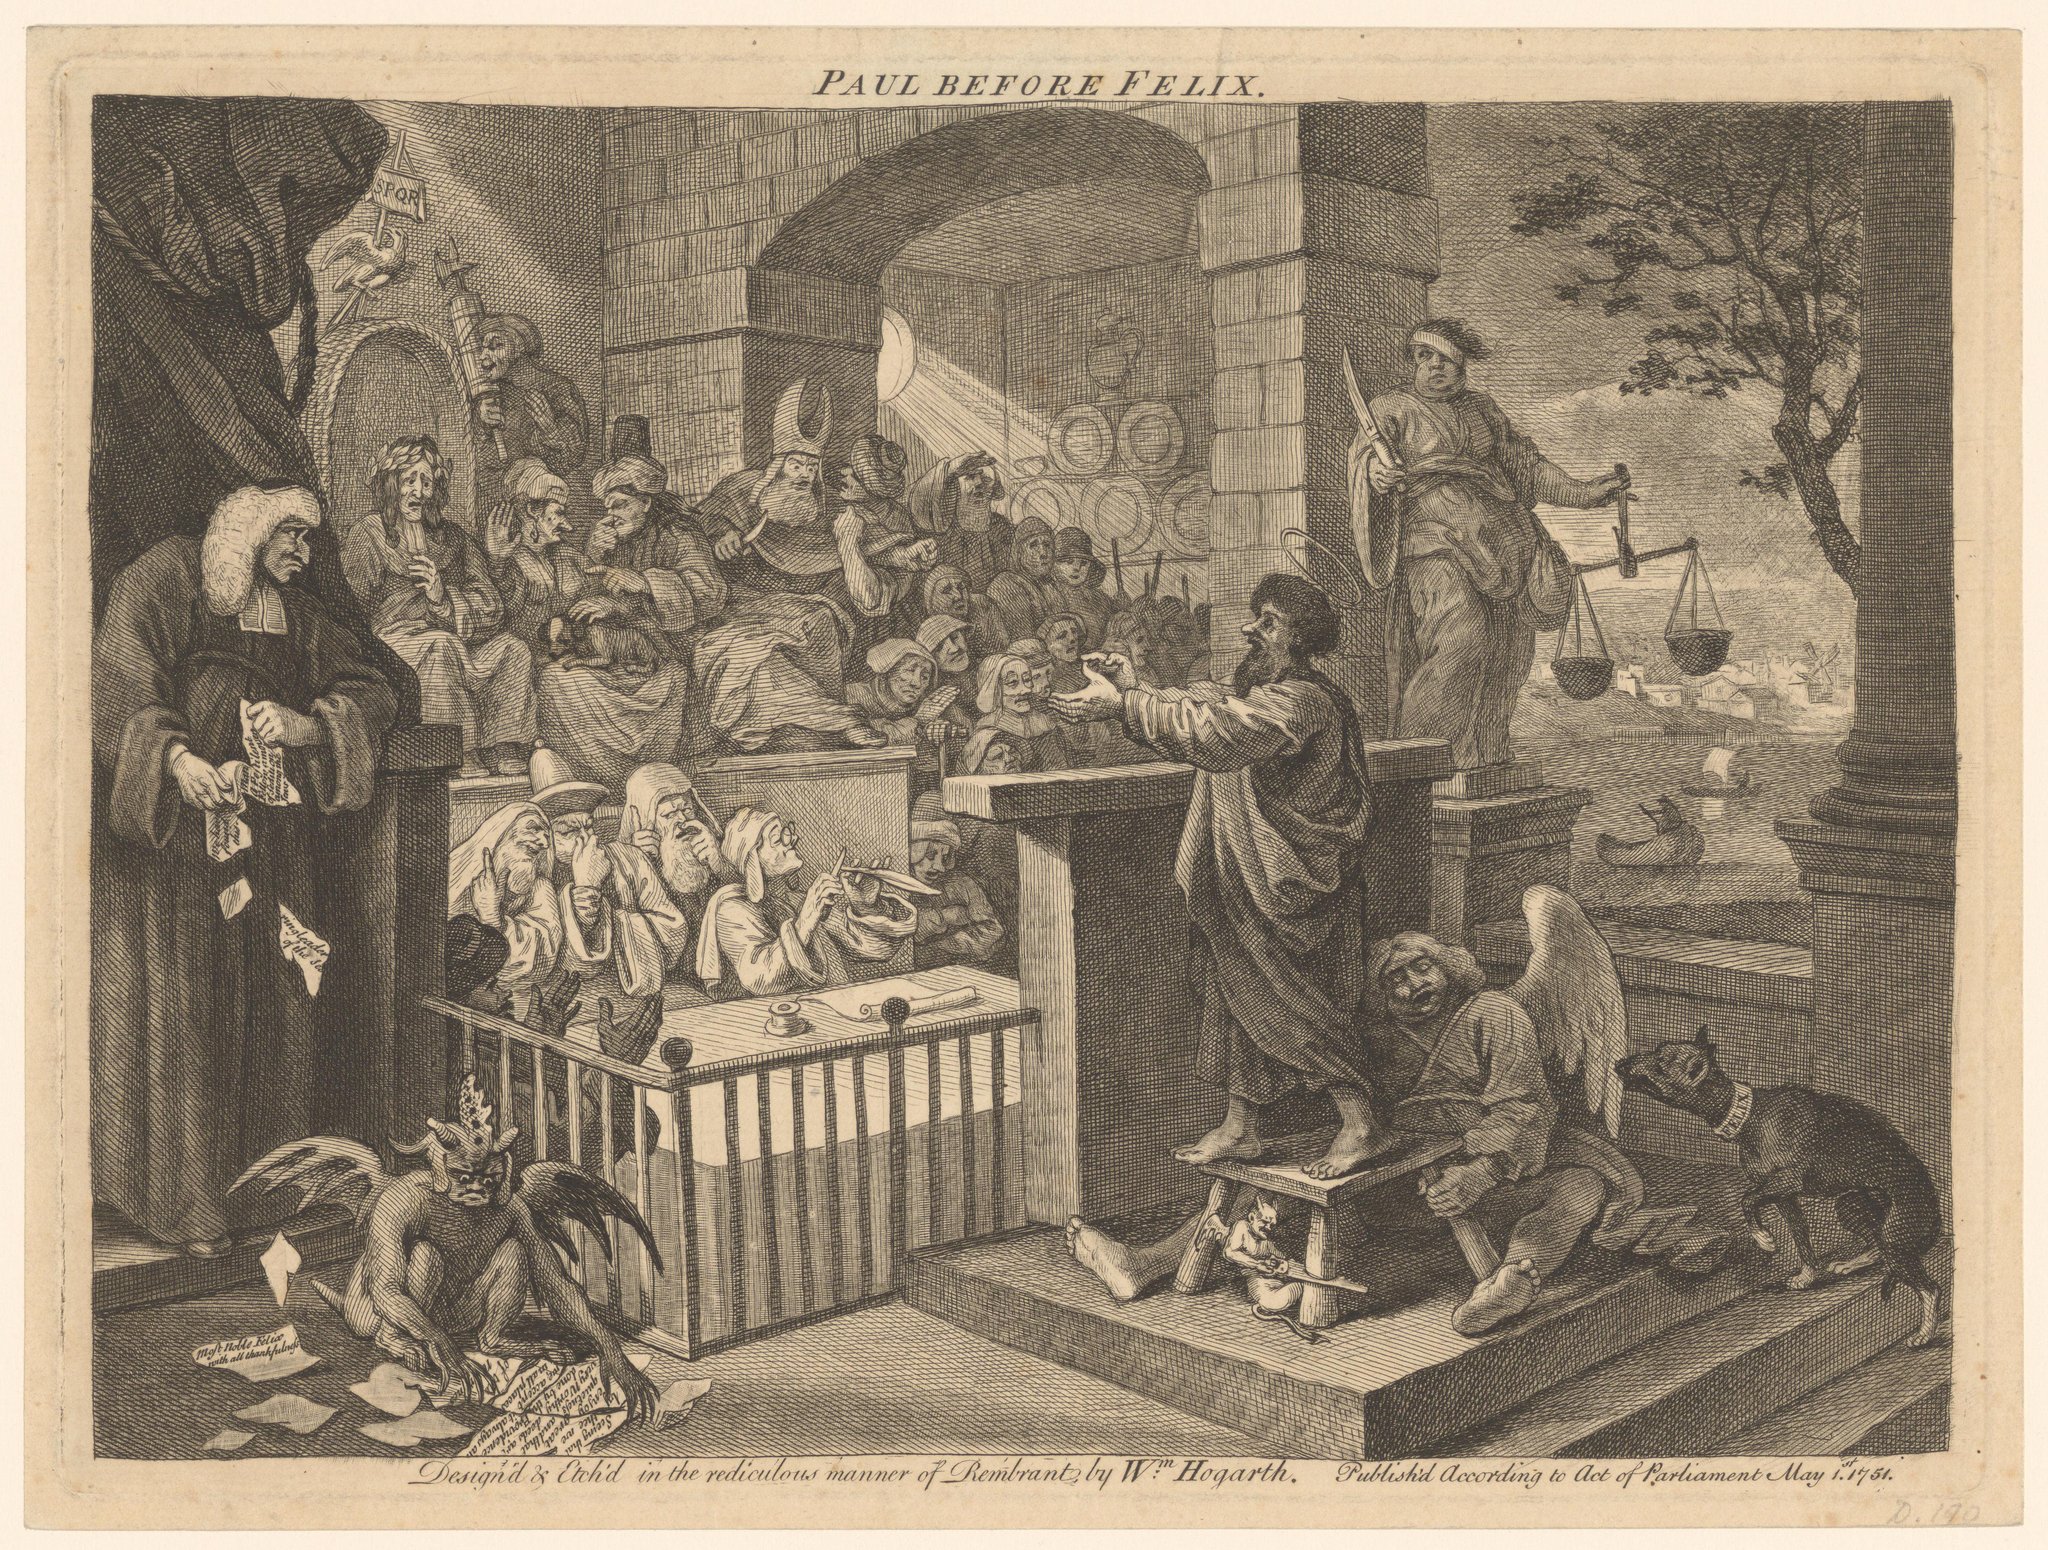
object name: print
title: Paulus voor Felix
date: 1751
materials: paper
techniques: engraving, etching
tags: paul is brought to caesarea by soldiers with a letter to felix, the governor, devil(s) and demons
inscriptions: collector's mark: Lugt 2228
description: Tekst in het Engels op de verscheurde brief en in de ondermarge. De apostel Paulus staat op een kruk voor het gerecht van Caesarea en richt zich tot Felix de gouverneur en procurator van Judea. Zijn vrouw Drusilla zit naast hem. De man links verscheurt een brief die aan Felix overhandigd had moeten worden ten behoeve van het lot van Paulus. De magistraten knijpen hun neus dicht.